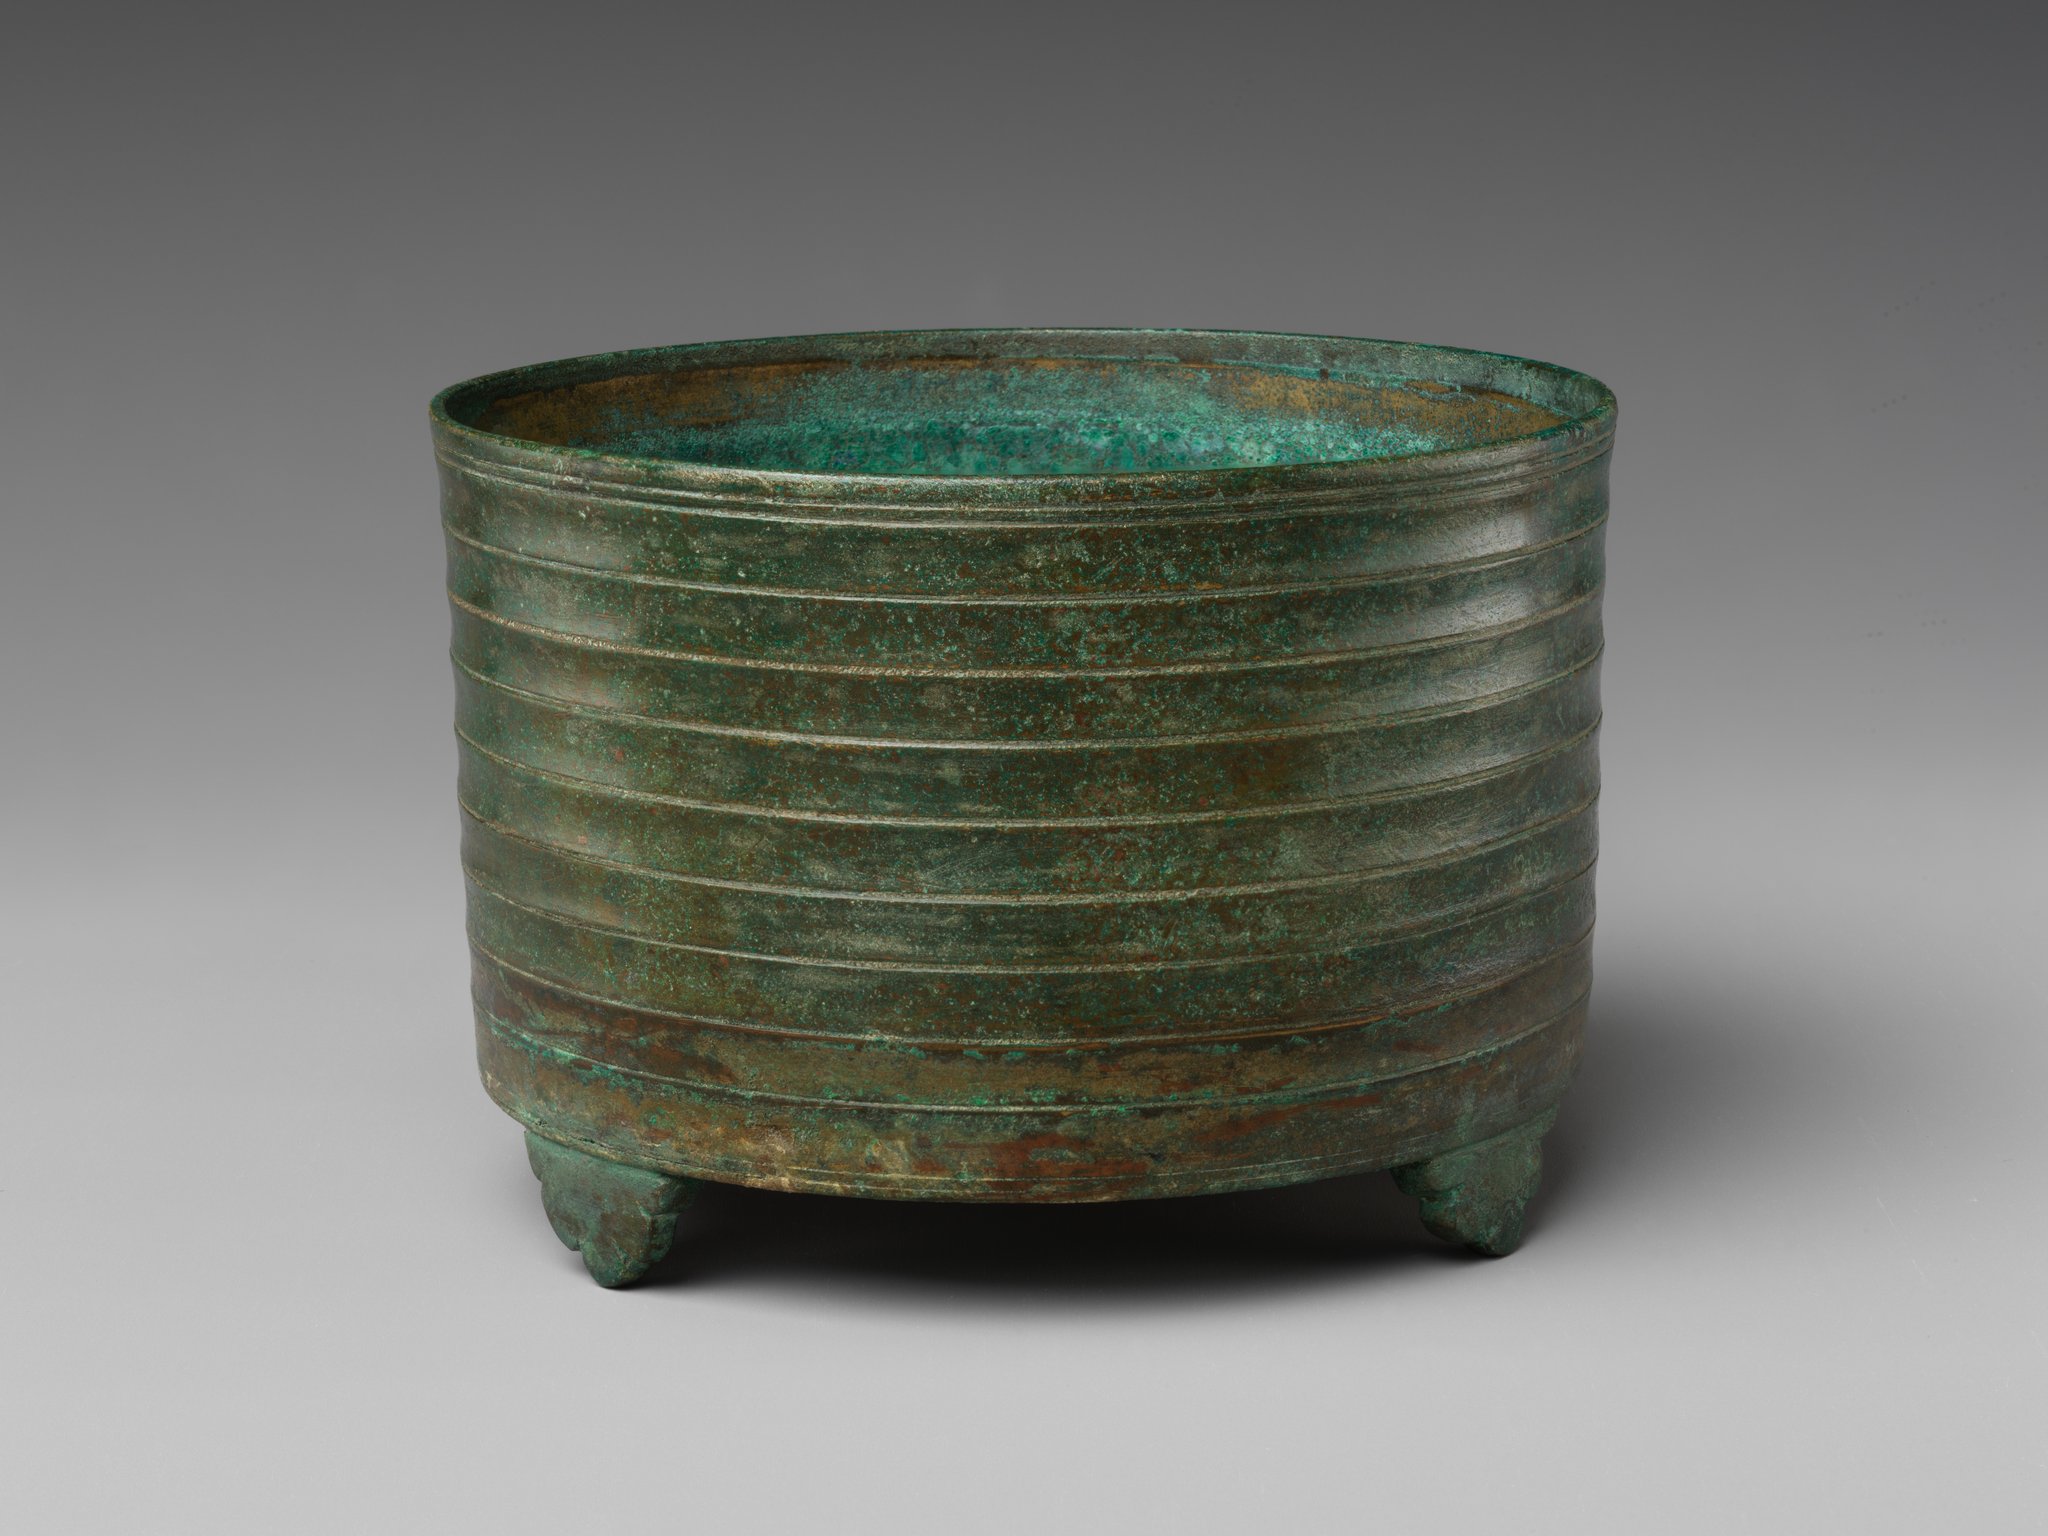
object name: censer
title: Incense burner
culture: chinese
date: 1101-1300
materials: copper alloy